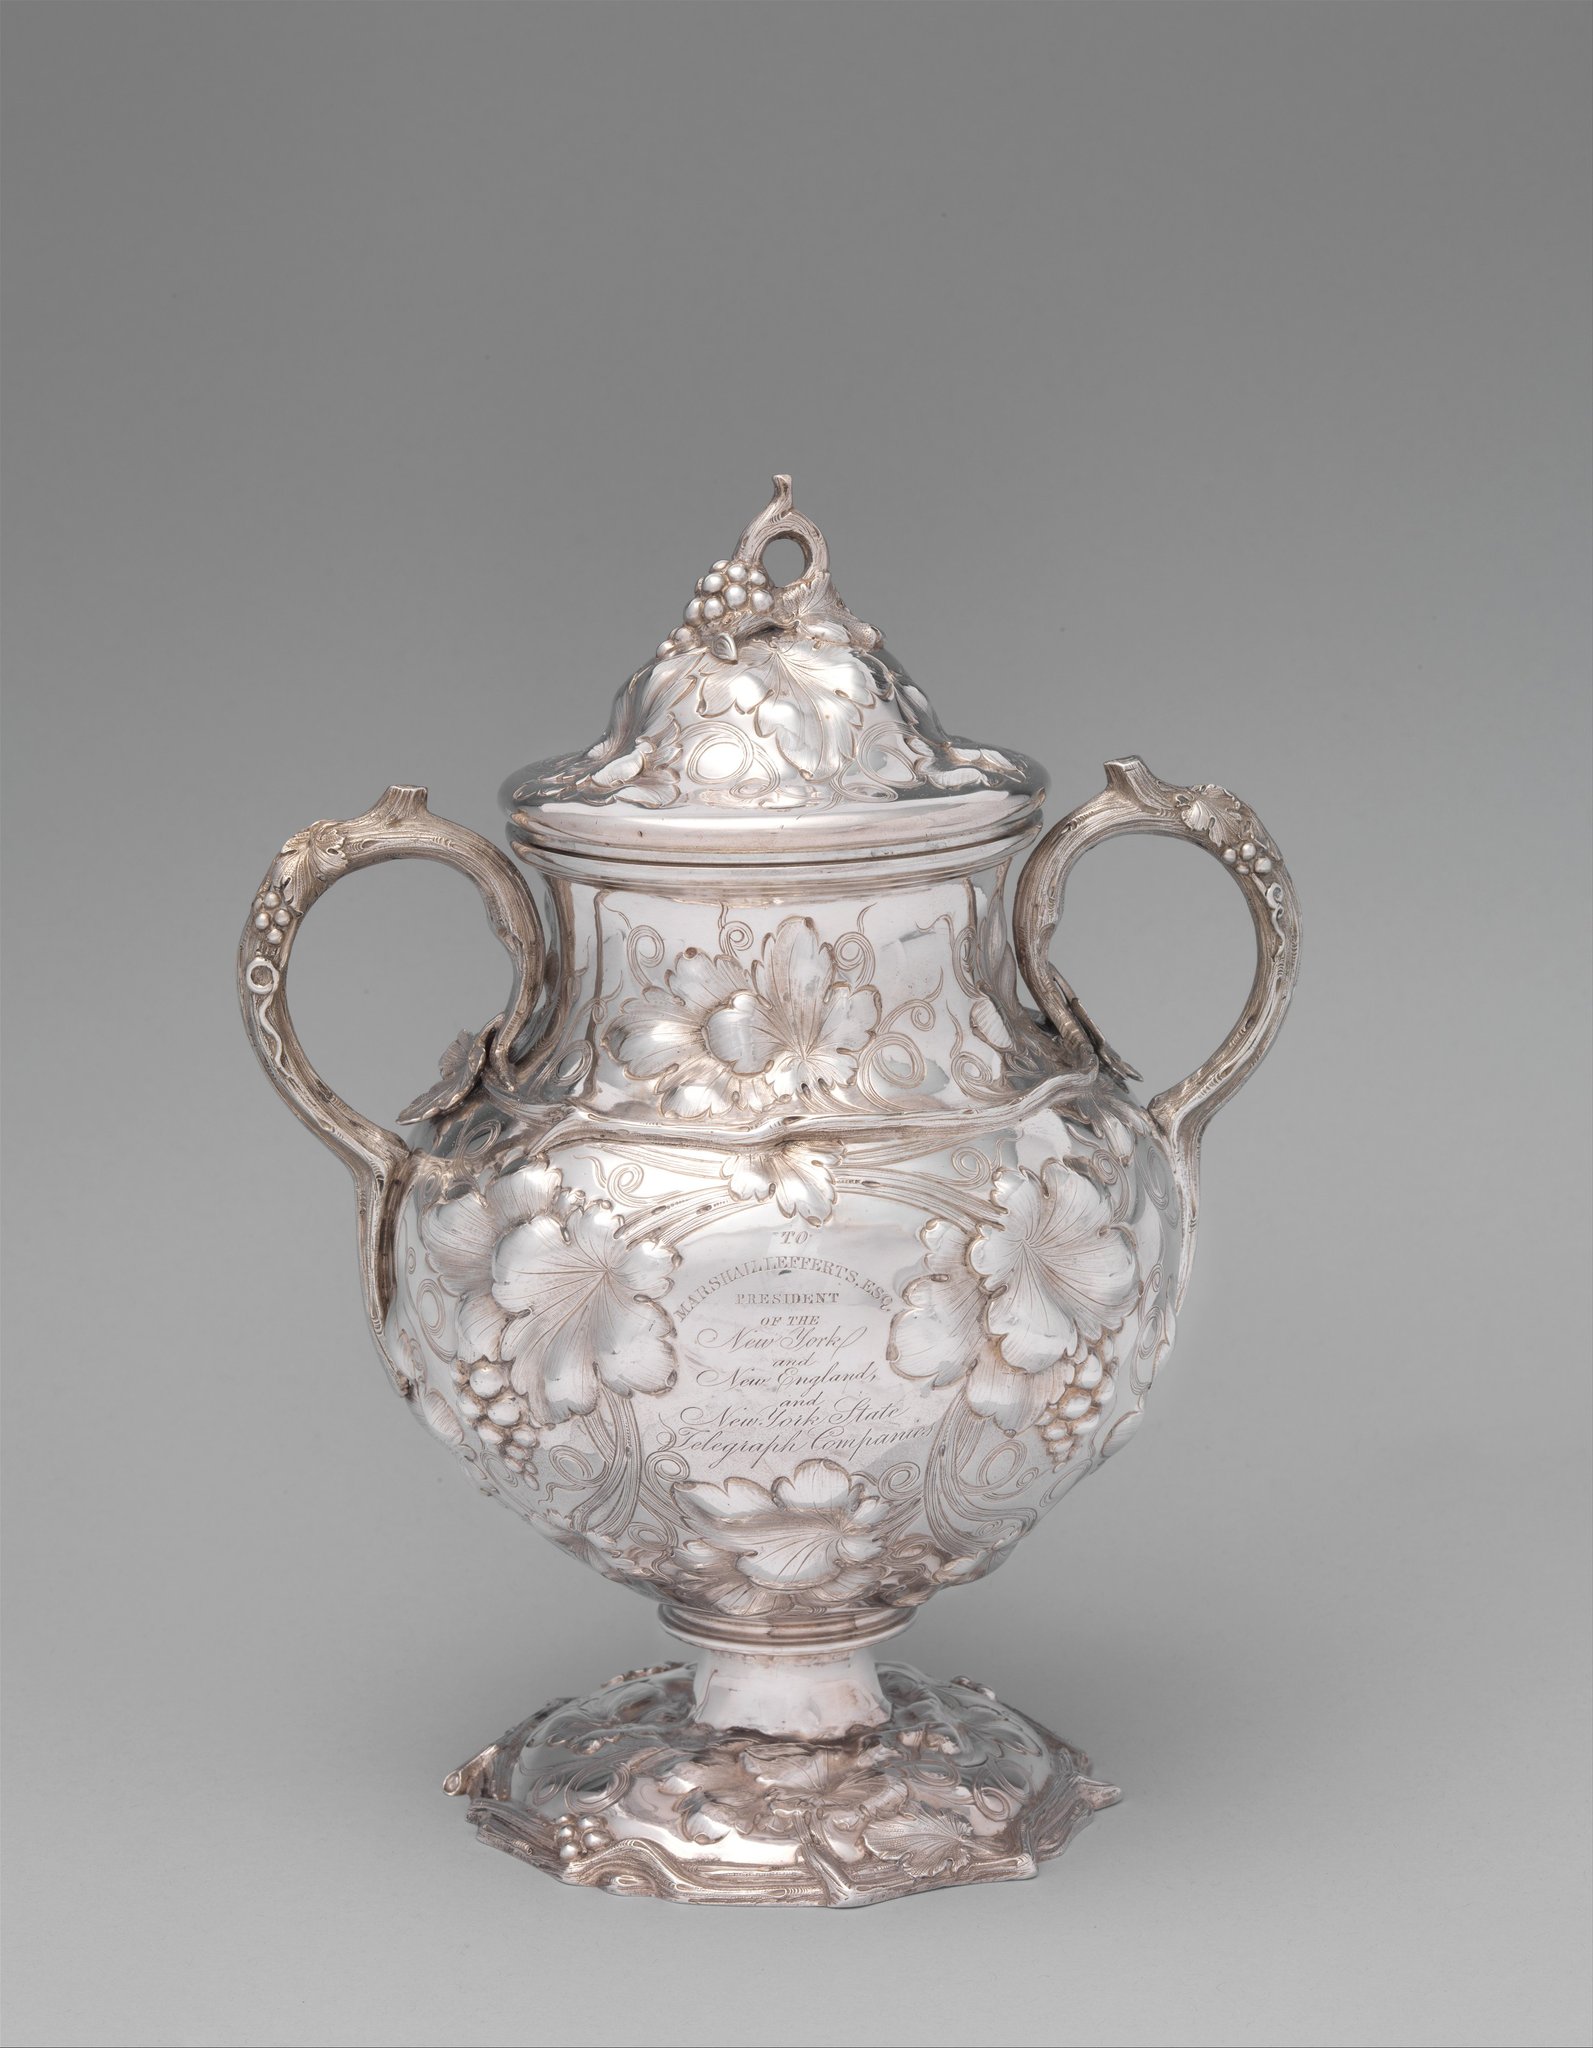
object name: sugar bowl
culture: american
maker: john c. moore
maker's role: maker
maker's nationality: american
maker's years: 1799-1874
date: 1850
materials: silver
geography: united states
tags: grapes